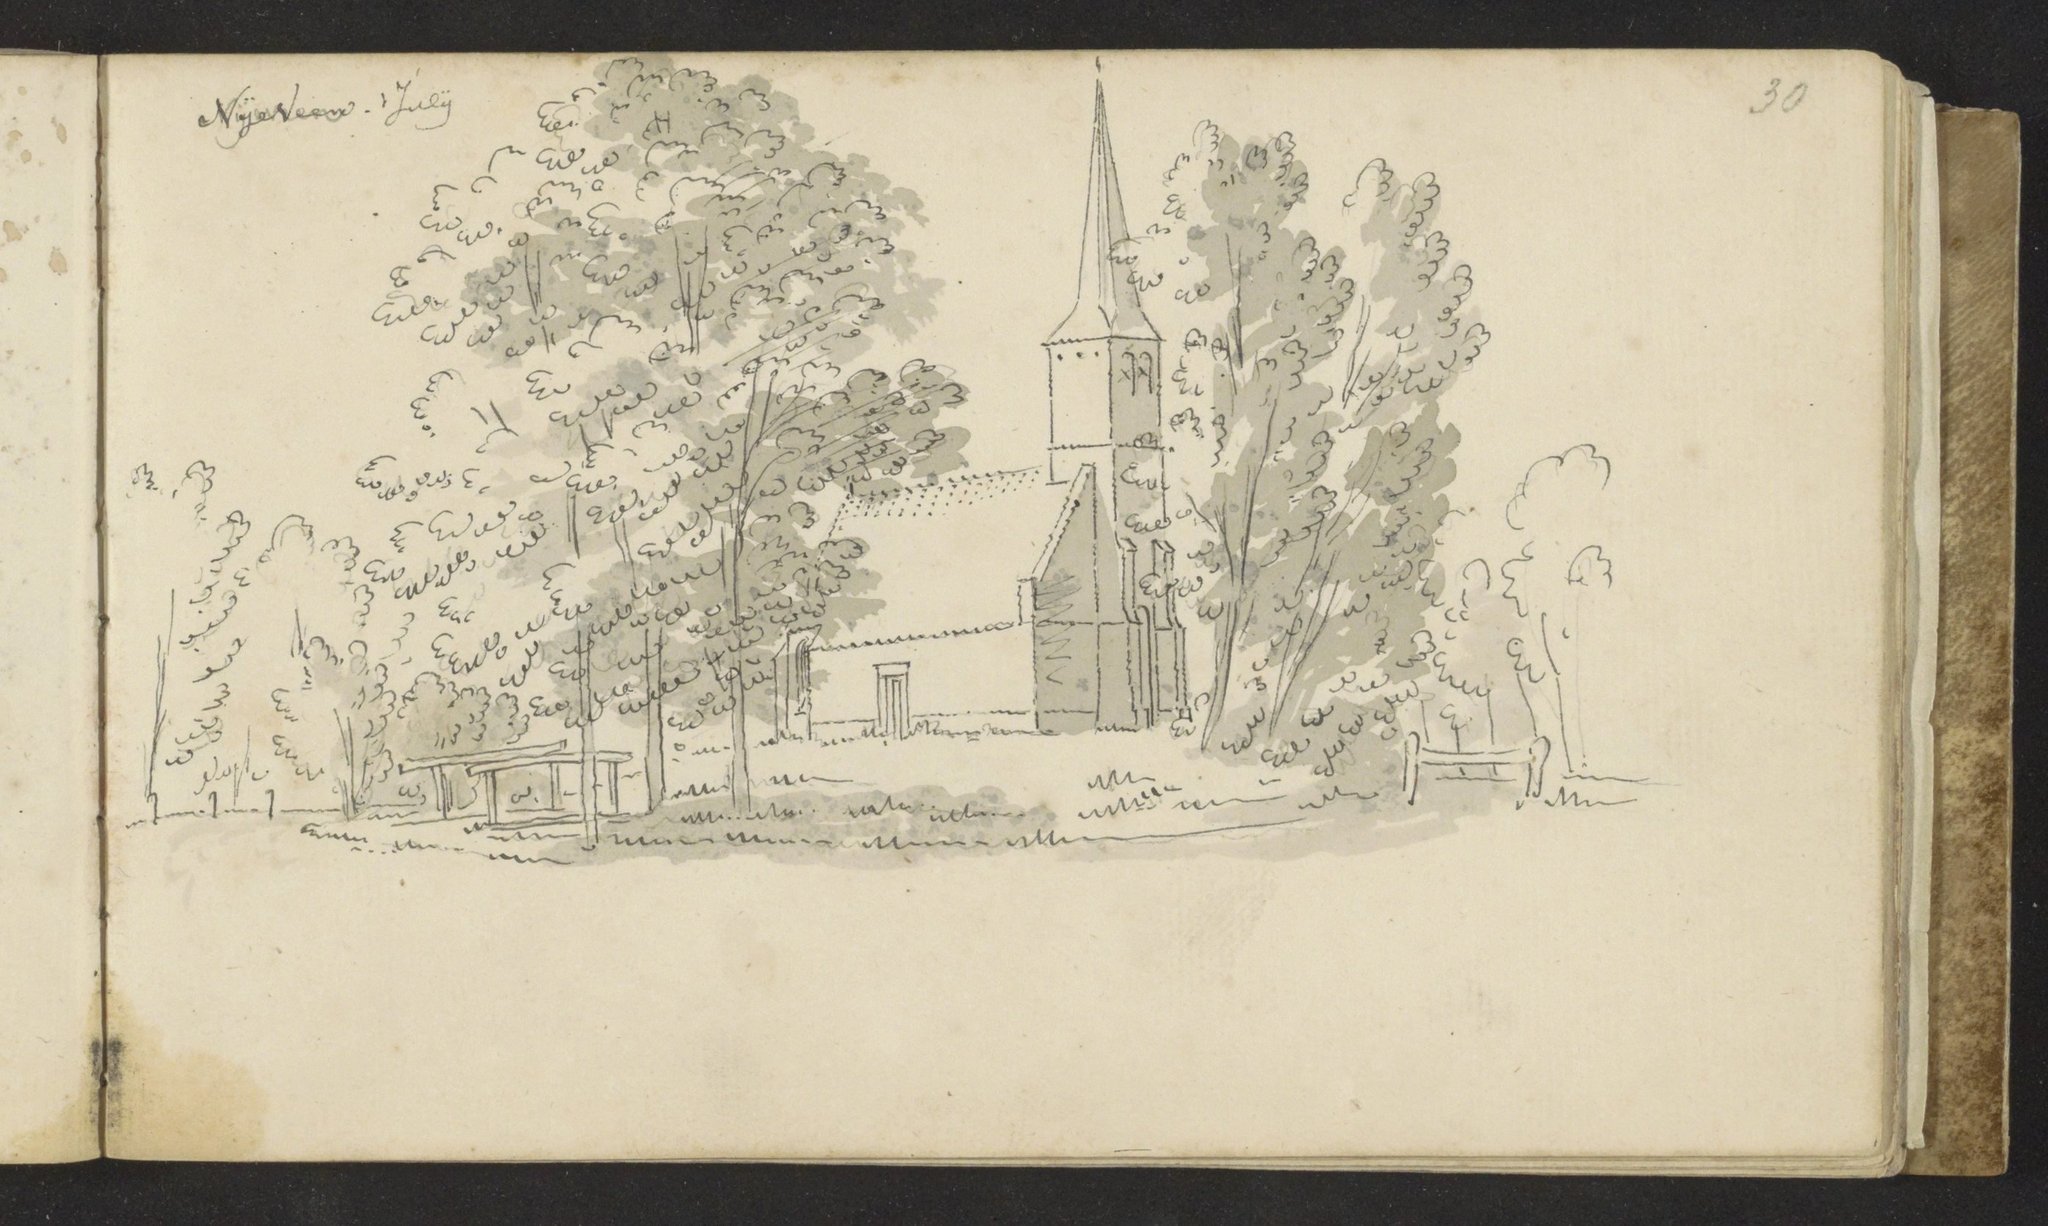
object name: sketchbook leaf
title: Dorpsgezicht te Nijeveen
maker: abraham de haen (ii)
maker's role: draughtsman, print maker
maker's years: 1707-1748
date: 1732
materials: ink, paper, pencil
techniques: brush, pen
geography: nijeveen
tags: village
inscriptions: date and inscription: ‘Nijeveen.1julij’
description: Blad 30 recto uit een schetsboek met 51 bladen.